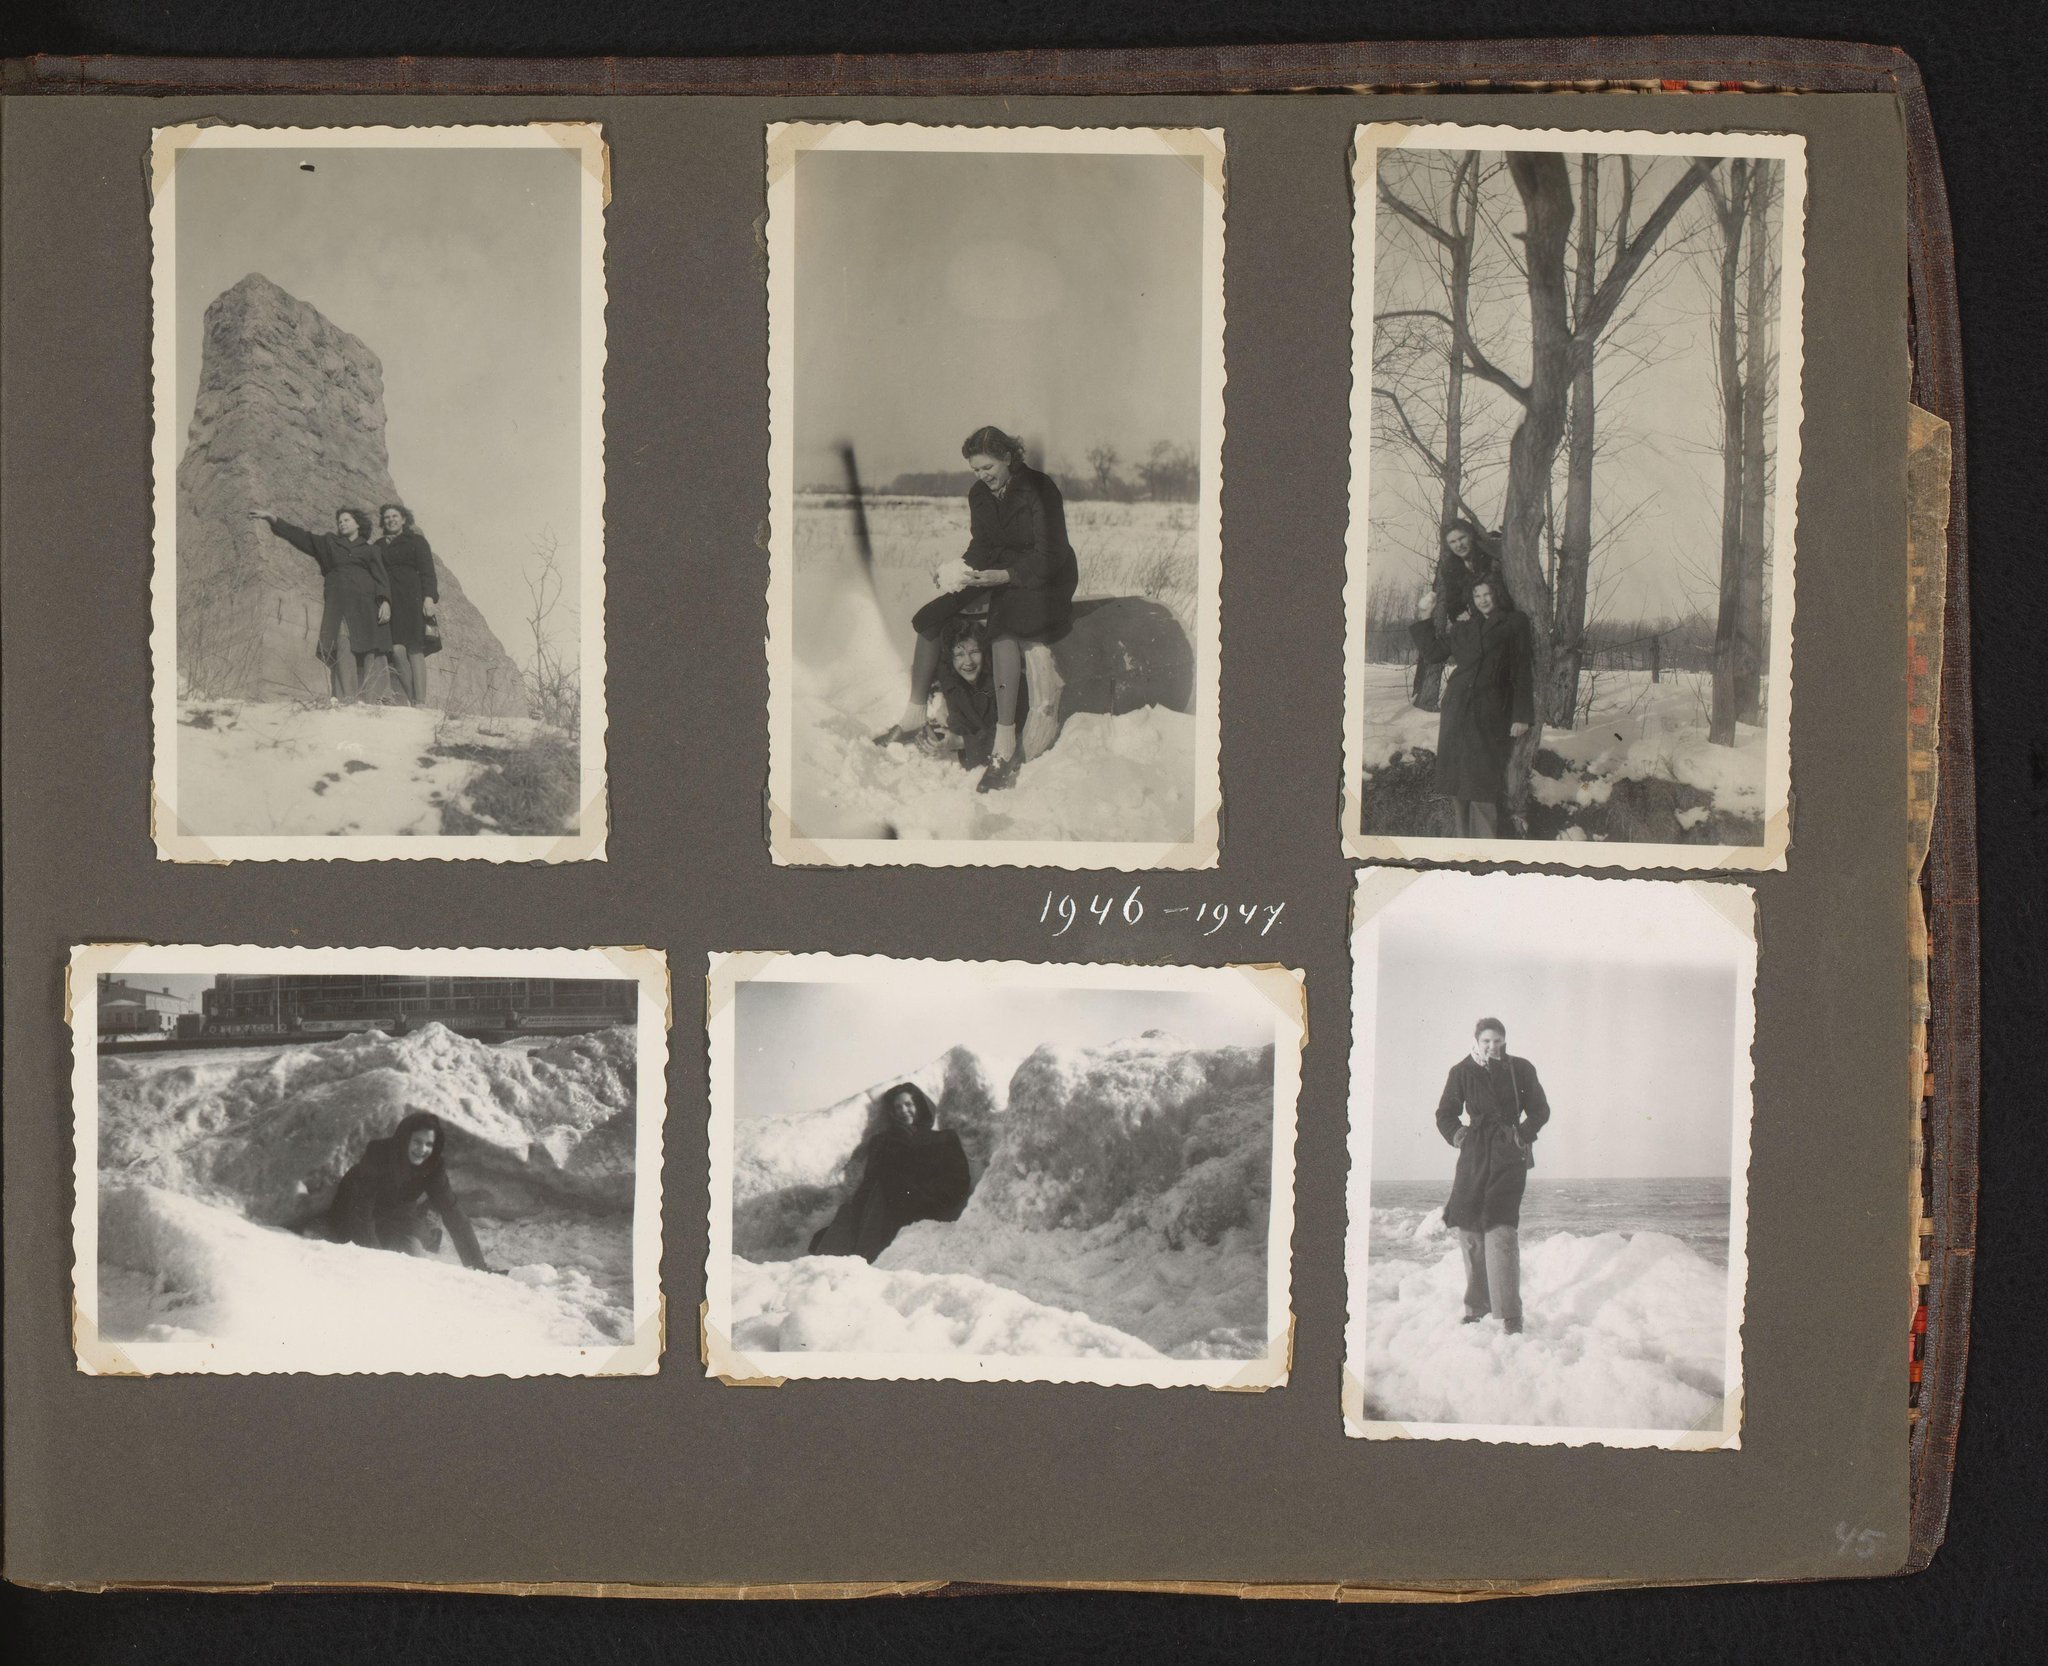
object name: album leaf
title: Winter 1946-1947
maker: Anonymous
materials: paper, photographic support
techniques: gelatin silver print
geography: netherlands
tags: beach (as place of recreation), enjoying nature, playing with snow and ice - cc - adult(s) ~ snow and ice, open-air recreation, severe winters, netherlands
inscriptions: inscription: ‘1946-1947’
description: Albumblad met zes foto's van een vriend en vriendin in de natuur en aan de kust met sneeuw en ijs tijdens de strenge winter van 1946-1947. Onderdeel van het Familiealbum 1940-1947.